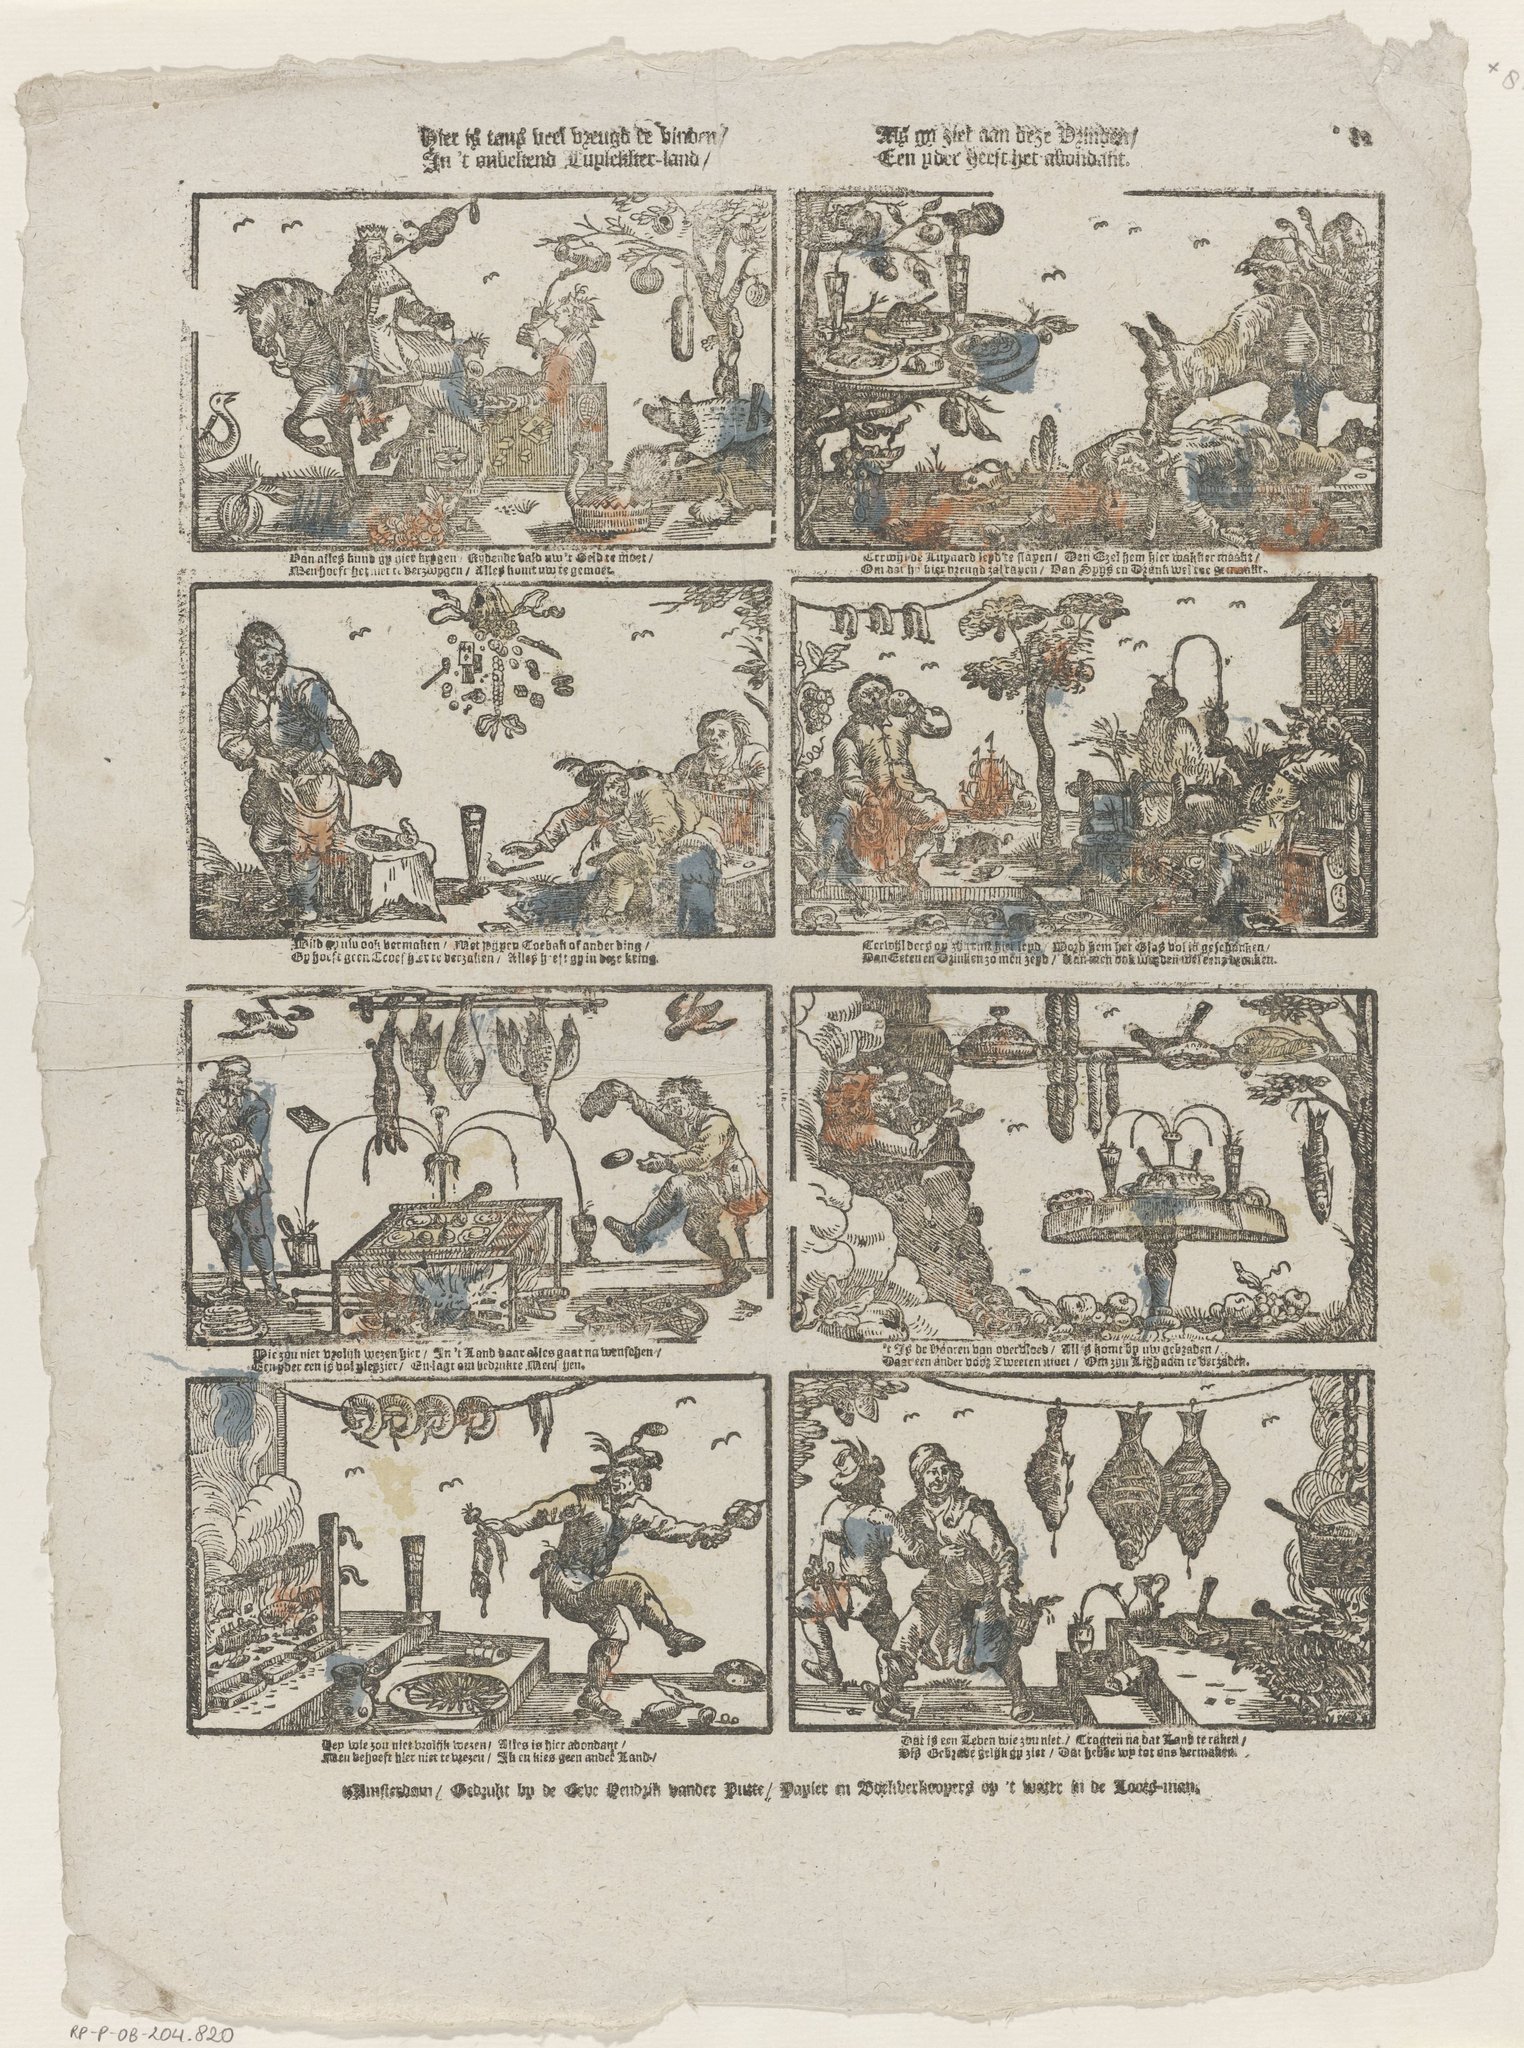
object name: print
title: Hier is tans veel vreugd te vinden / In 't onbekend Luylekker-land / Als gy ziet aan deze vrinden / Een yder heeft het abondant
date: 1767-1793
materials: paper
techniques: colour, letterpress printing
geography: amsterdam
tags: land of cockaigne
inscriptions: collector's mark: Lugt 2760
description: Uitgave van nr. *82 uit de fondslijst van Johannes Kannewet (II) met het adres van de wederverkoper Erven Hendrik van der Putte.